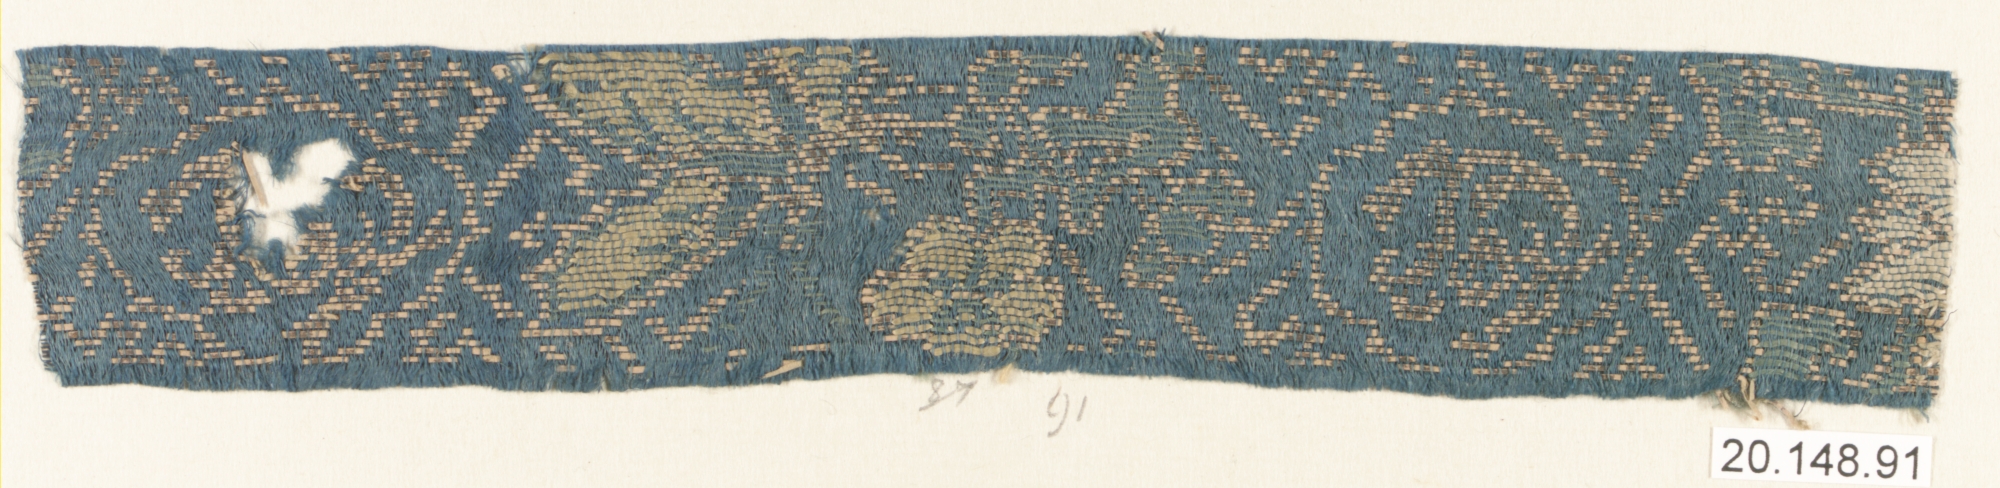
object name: piece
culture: chinese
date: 1601-1700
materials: silk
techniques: compound weave